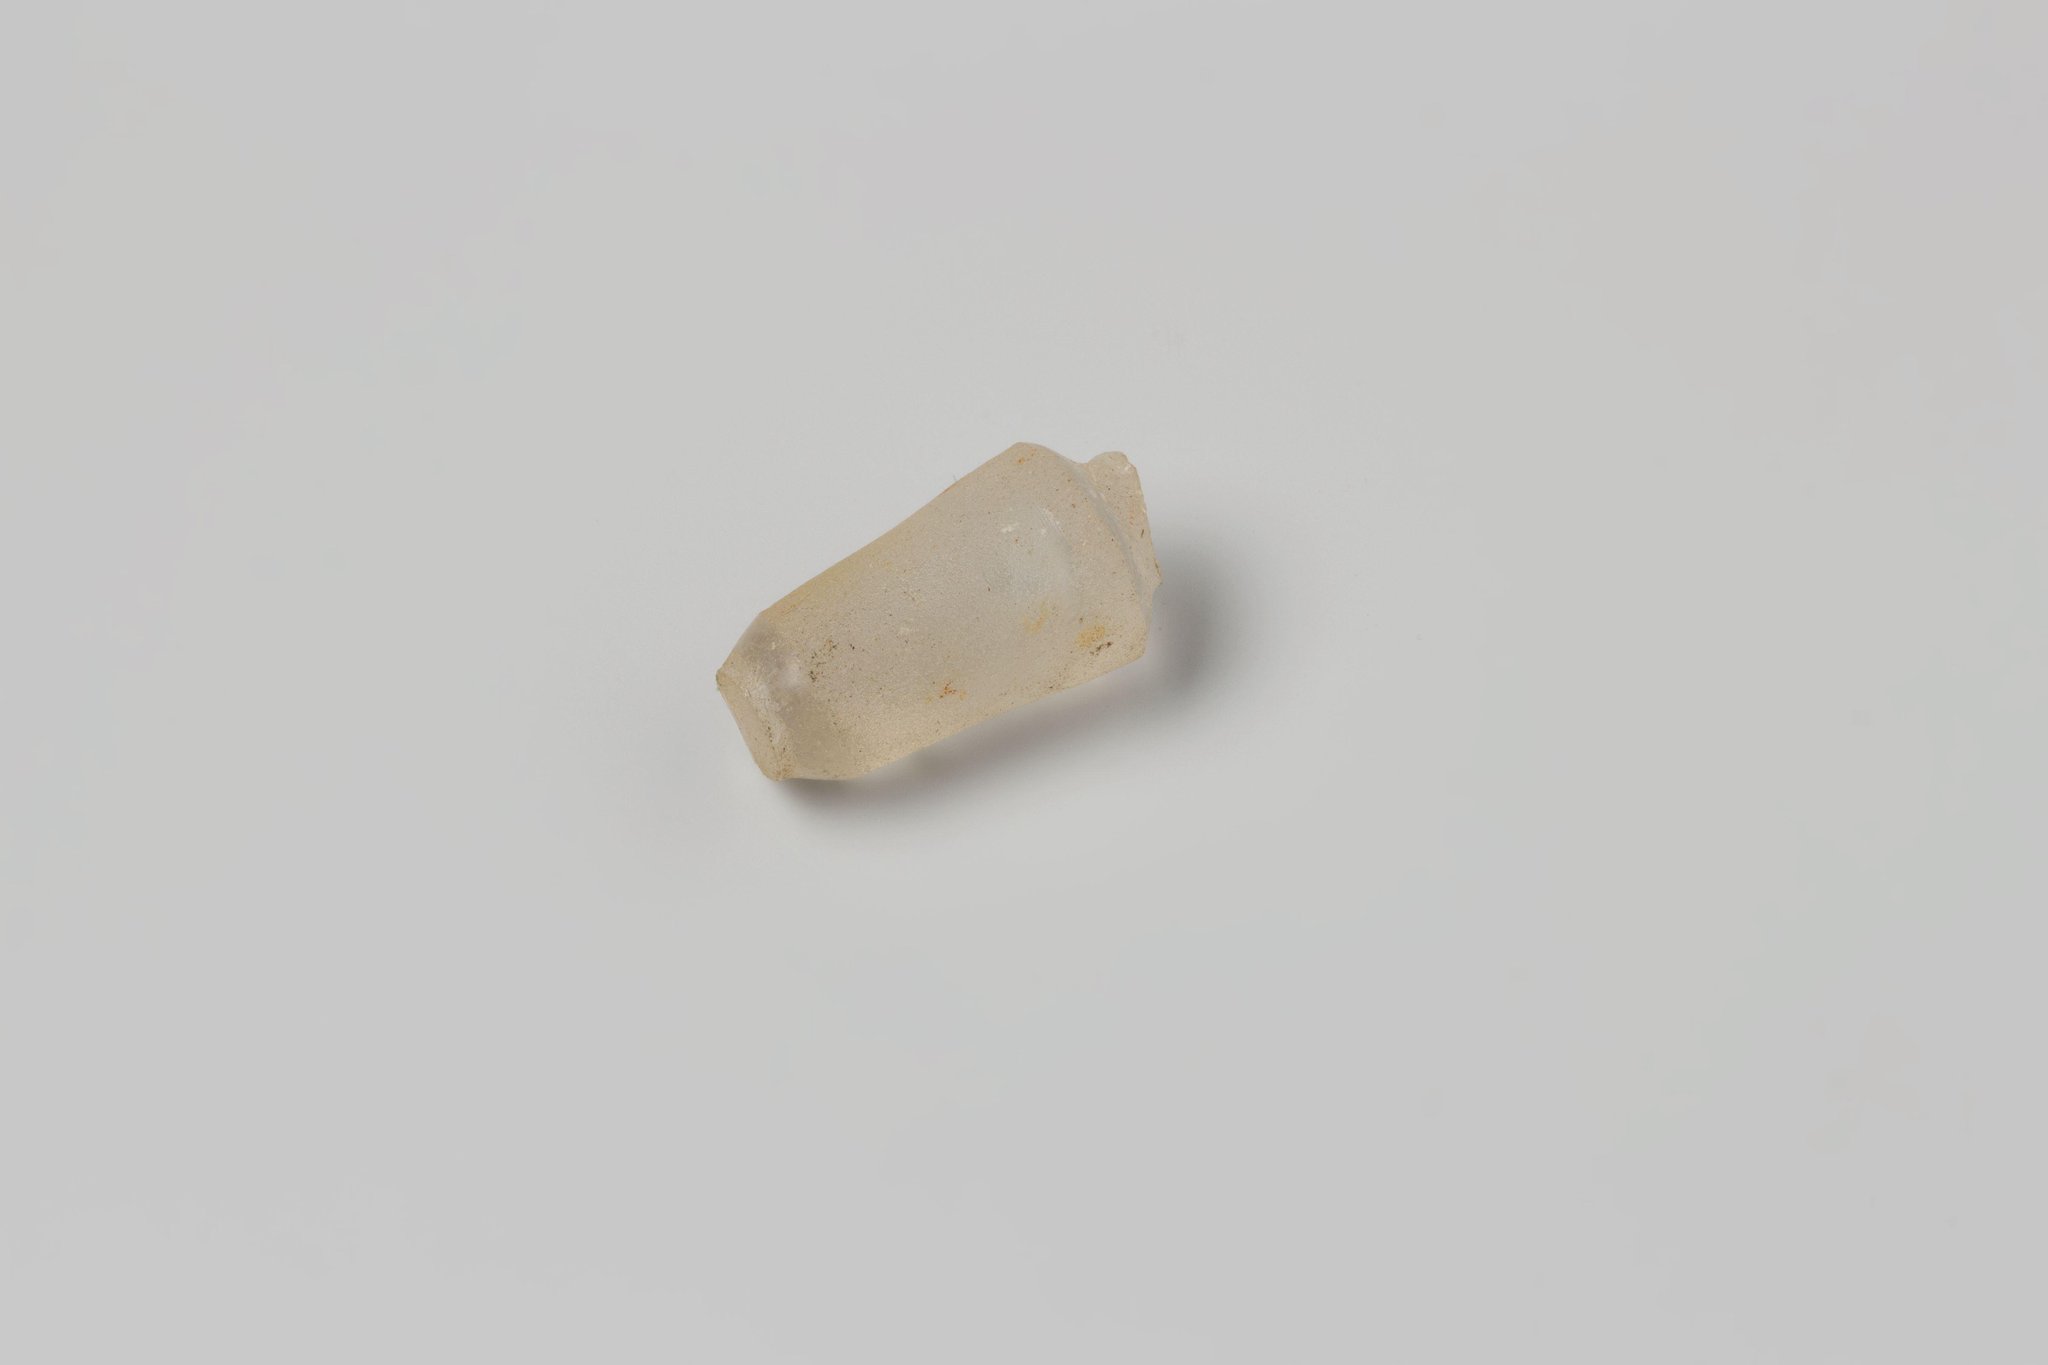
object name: vessel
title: Fragment stop van vaatwerk uit het wrak van de Oost-Indiëvaarder Hollandia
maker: Anonymous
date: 1700-1743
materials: glass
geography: netherlands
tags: verenigde oostindische compagnie, hollandia (schip), annet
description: Vessel part, stopper; fragm, id. NG 1979-527H, finial broken off.